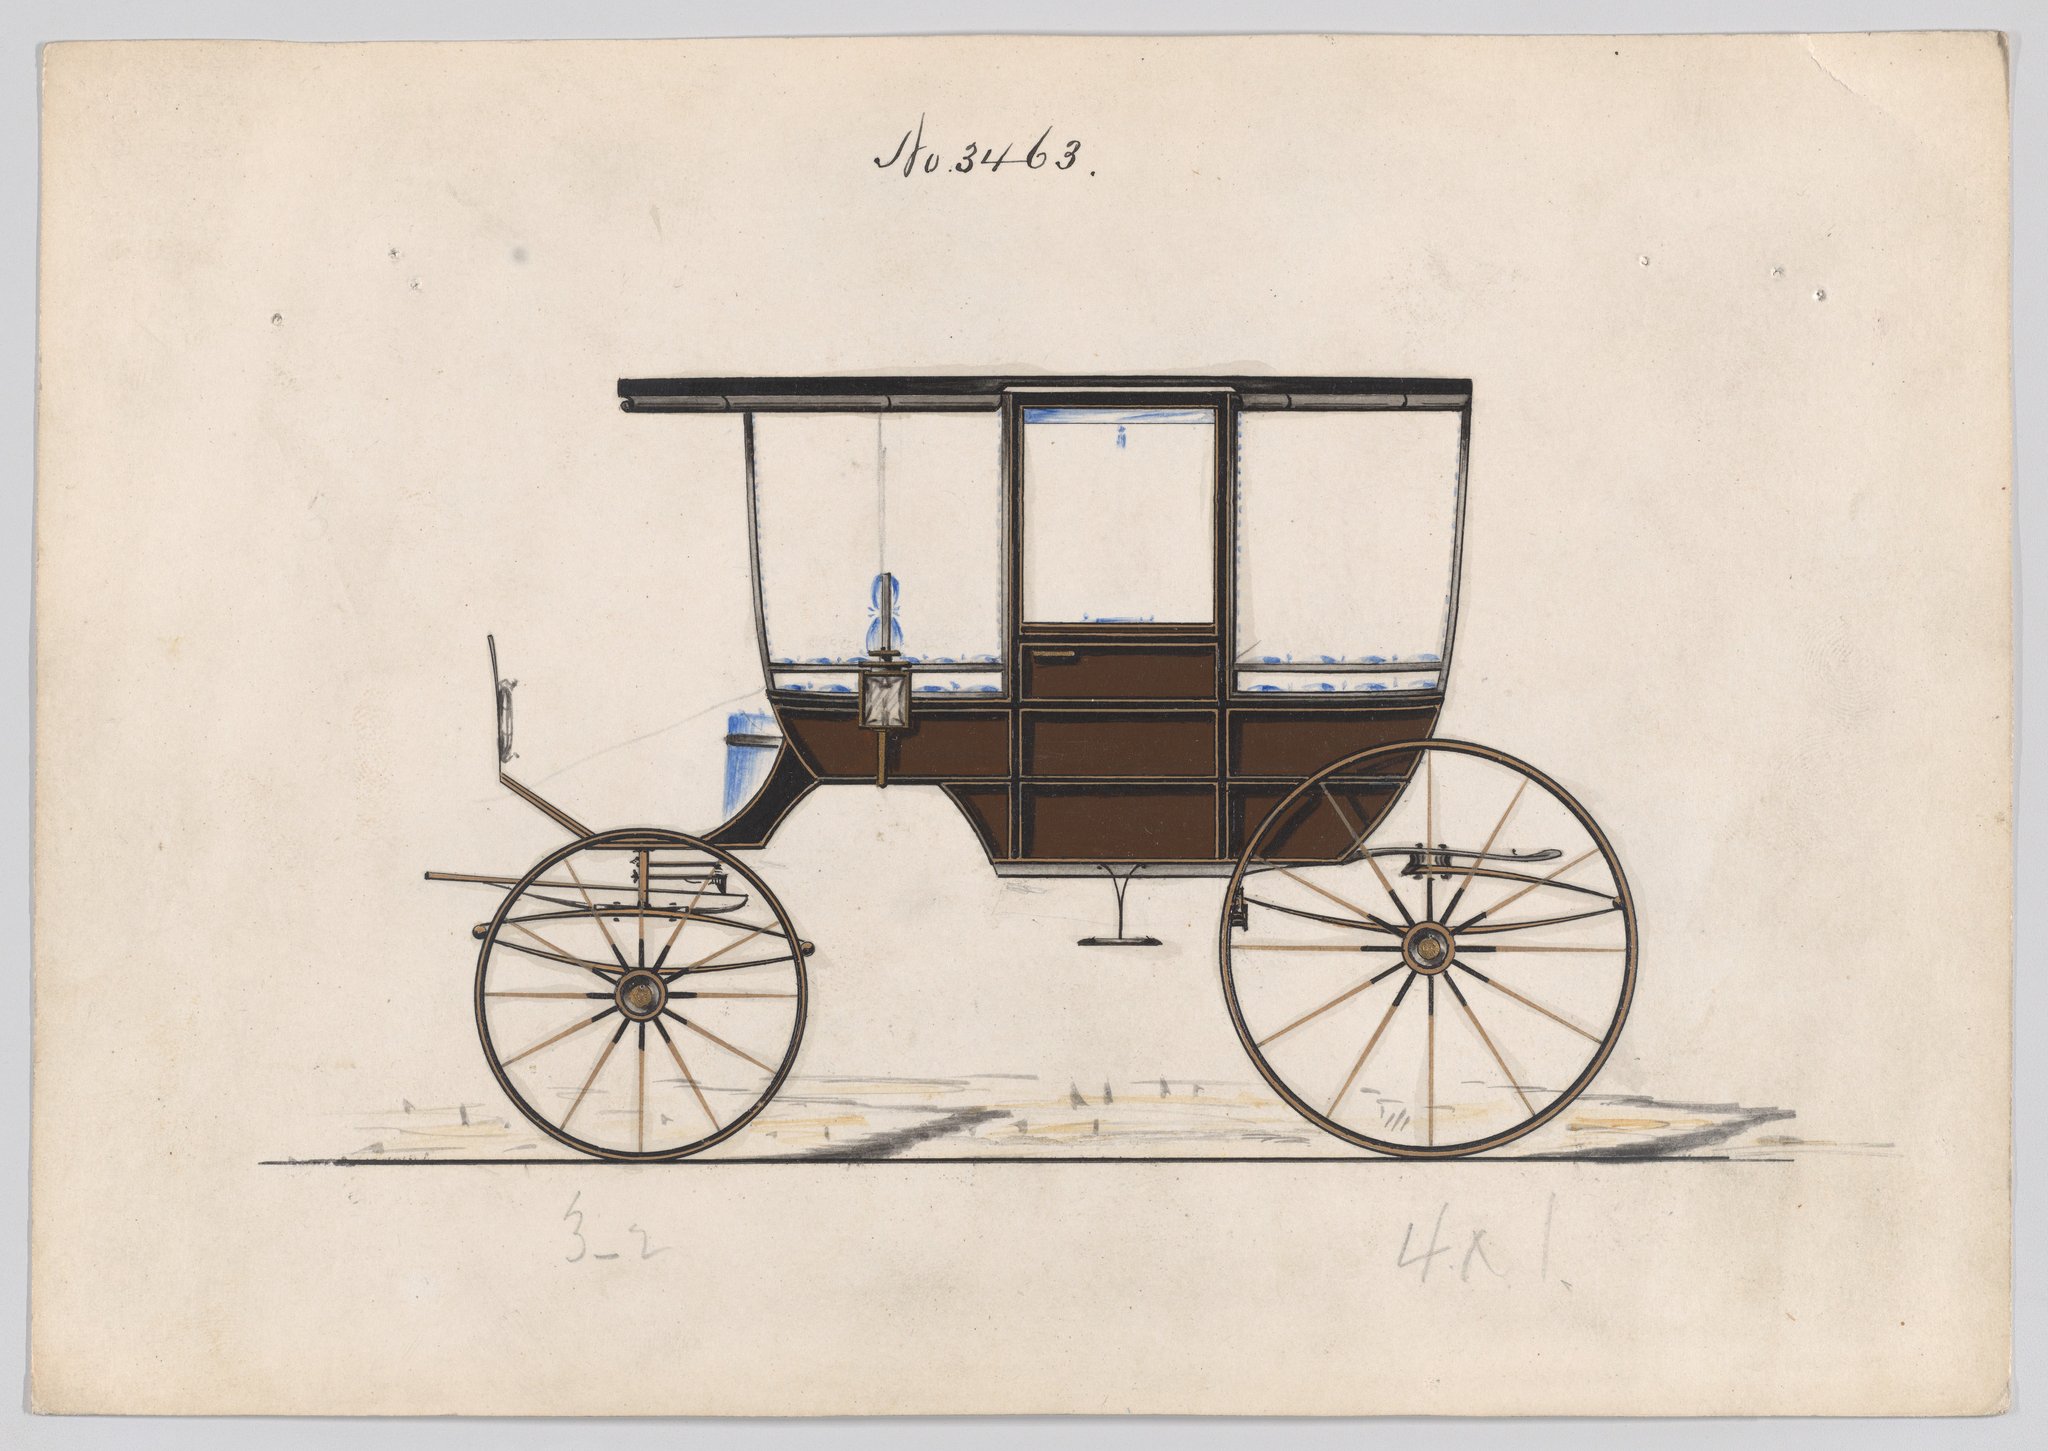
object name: drawing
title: Design for 6 seat Rockaway, no. 3463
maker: brewster & co.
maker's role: manufacturer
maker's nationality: american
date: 1878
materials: gouache, gum arabic, ink, watercolor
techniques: pen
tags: carriages